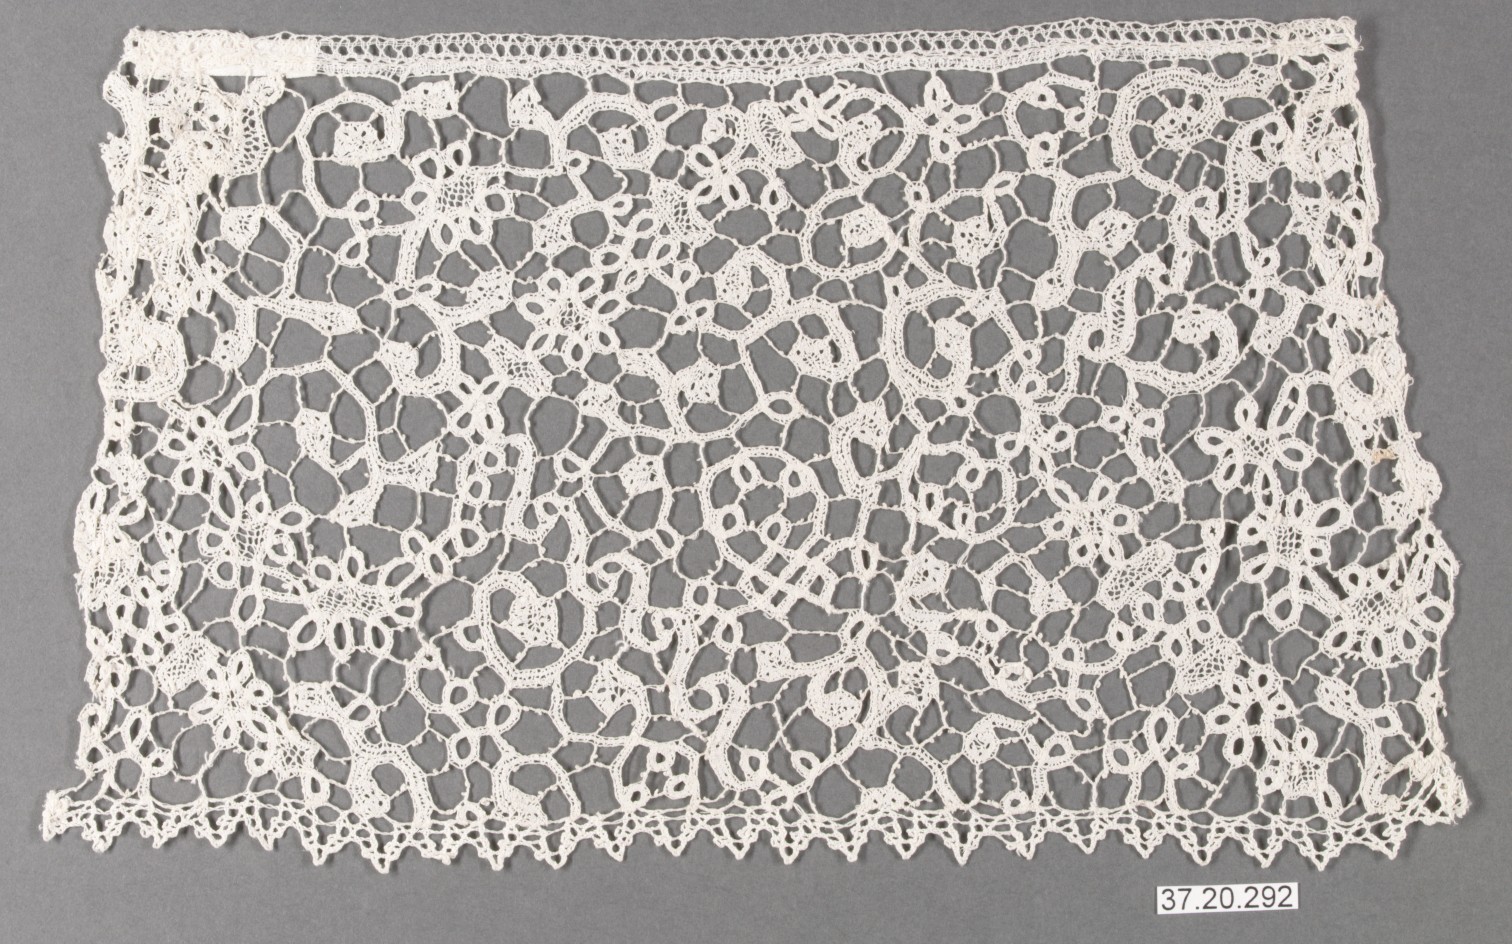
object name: fragment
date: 1601-1700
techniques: lace